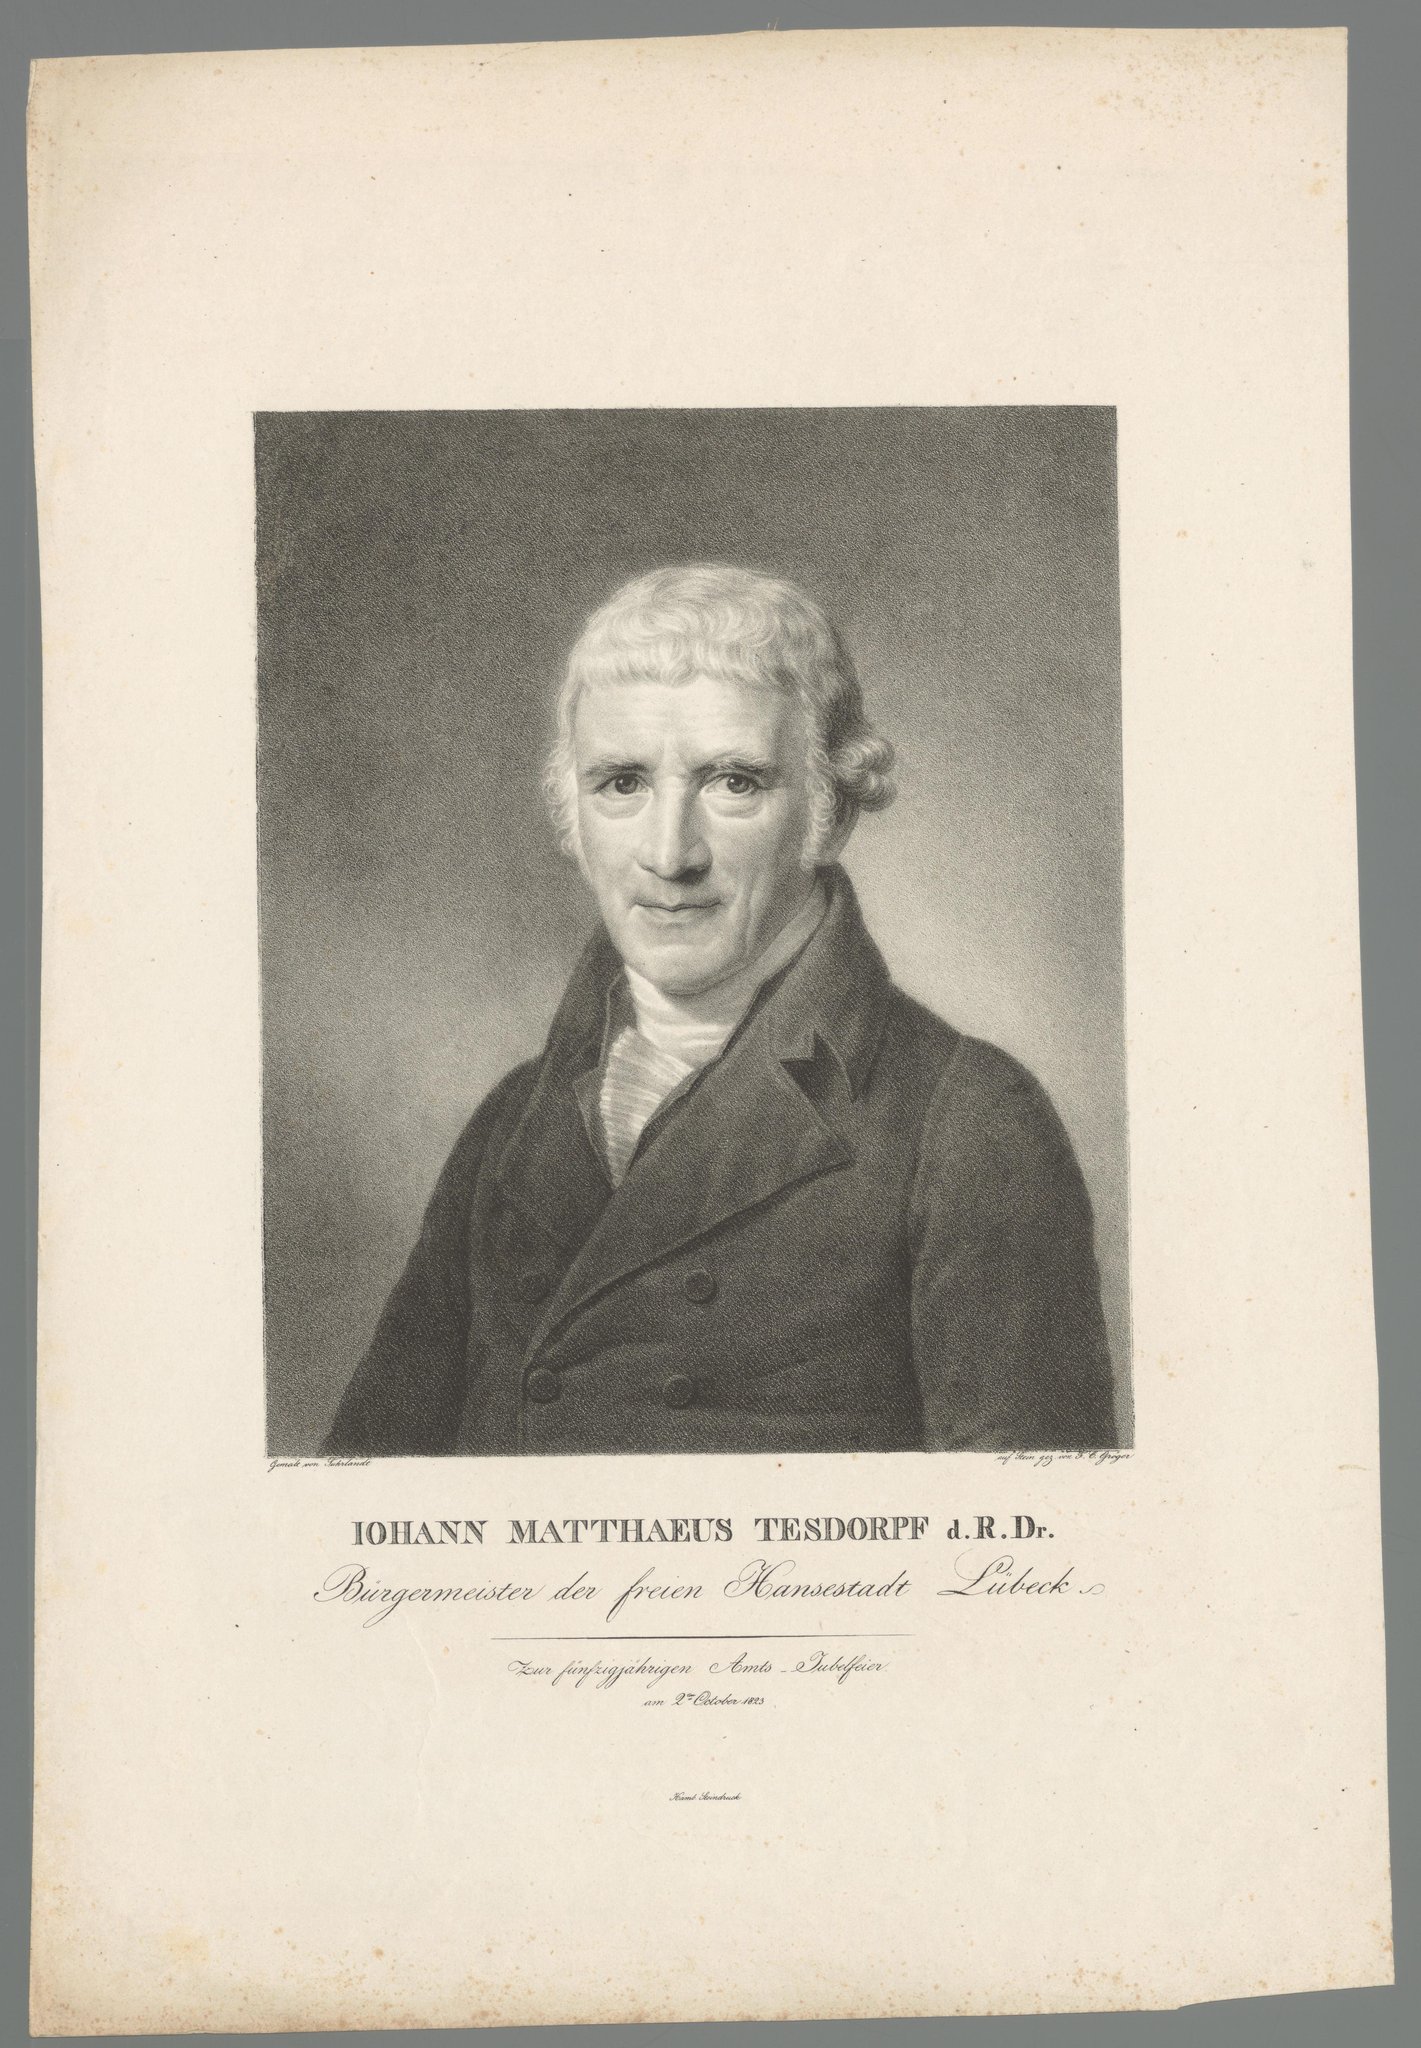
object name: print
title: Johann Matthaeus Tesdorpf d.R.Dr.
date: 1823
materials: paper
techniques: lithograph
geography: hamburg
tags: politician, adult man, historical persons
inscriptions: collector's mark: Lugt 2228